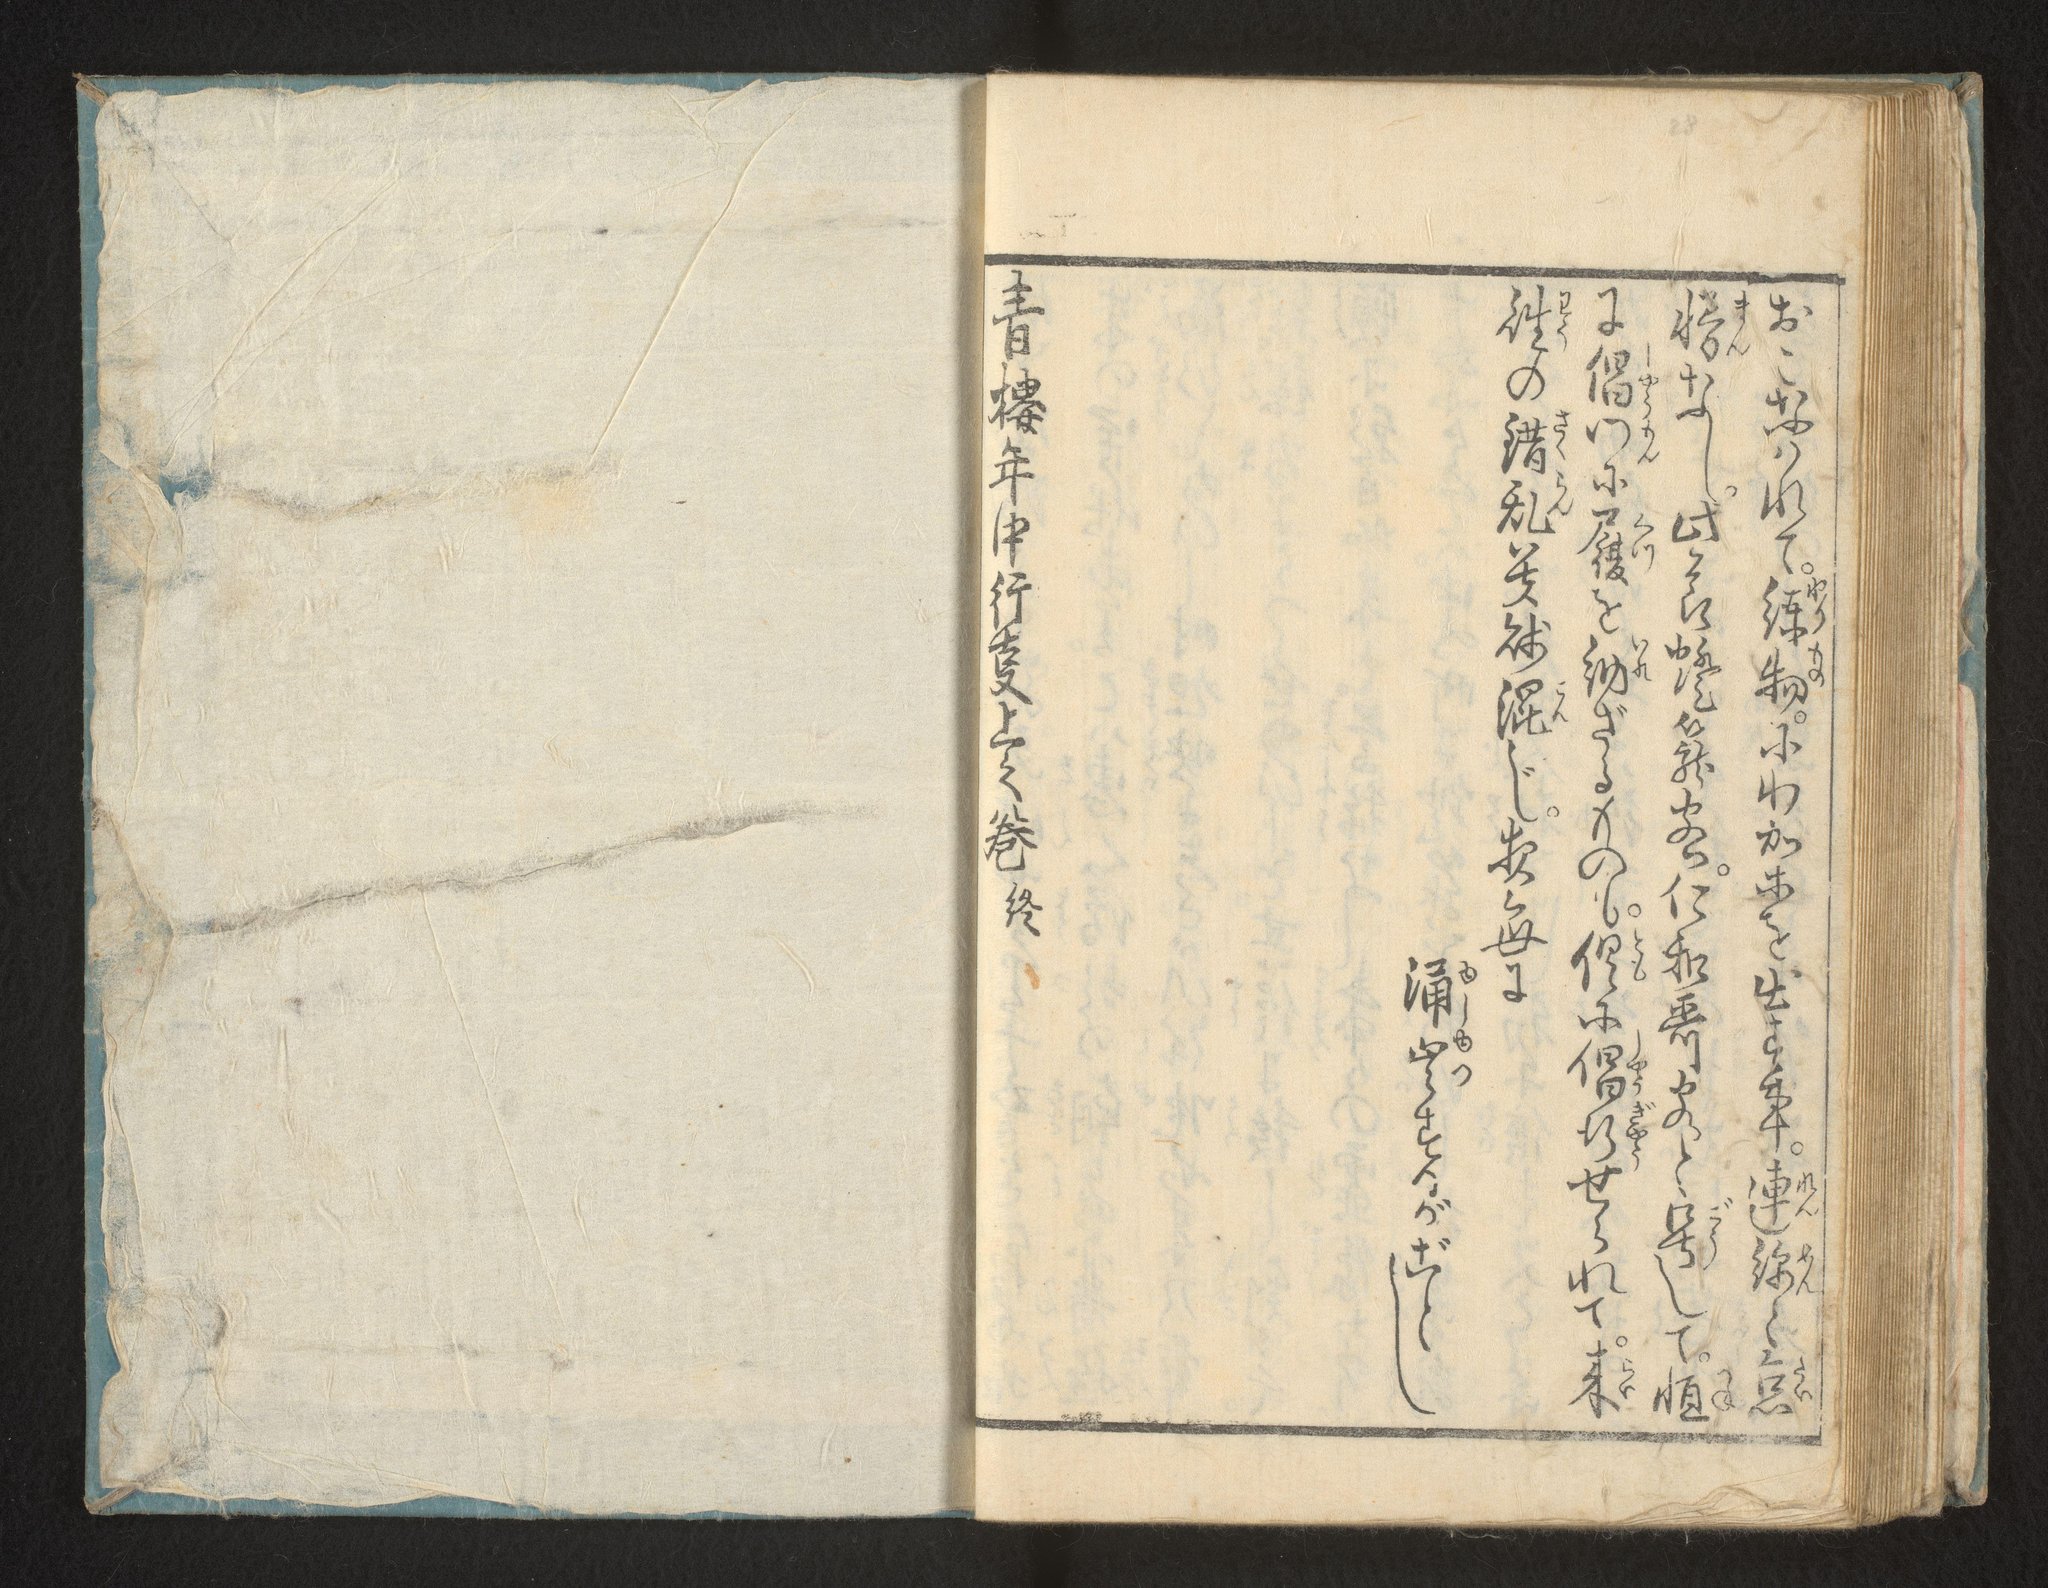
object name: page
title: Tekst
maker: jippensha ikku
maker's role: schrijver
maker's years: 1765-1831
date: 1804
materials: paper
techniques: woodcut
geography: edo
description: Laatste pagina van deel één van Utamaro`s boek: Gebeurtenissen in de lusthuizen gedurende het jaar.